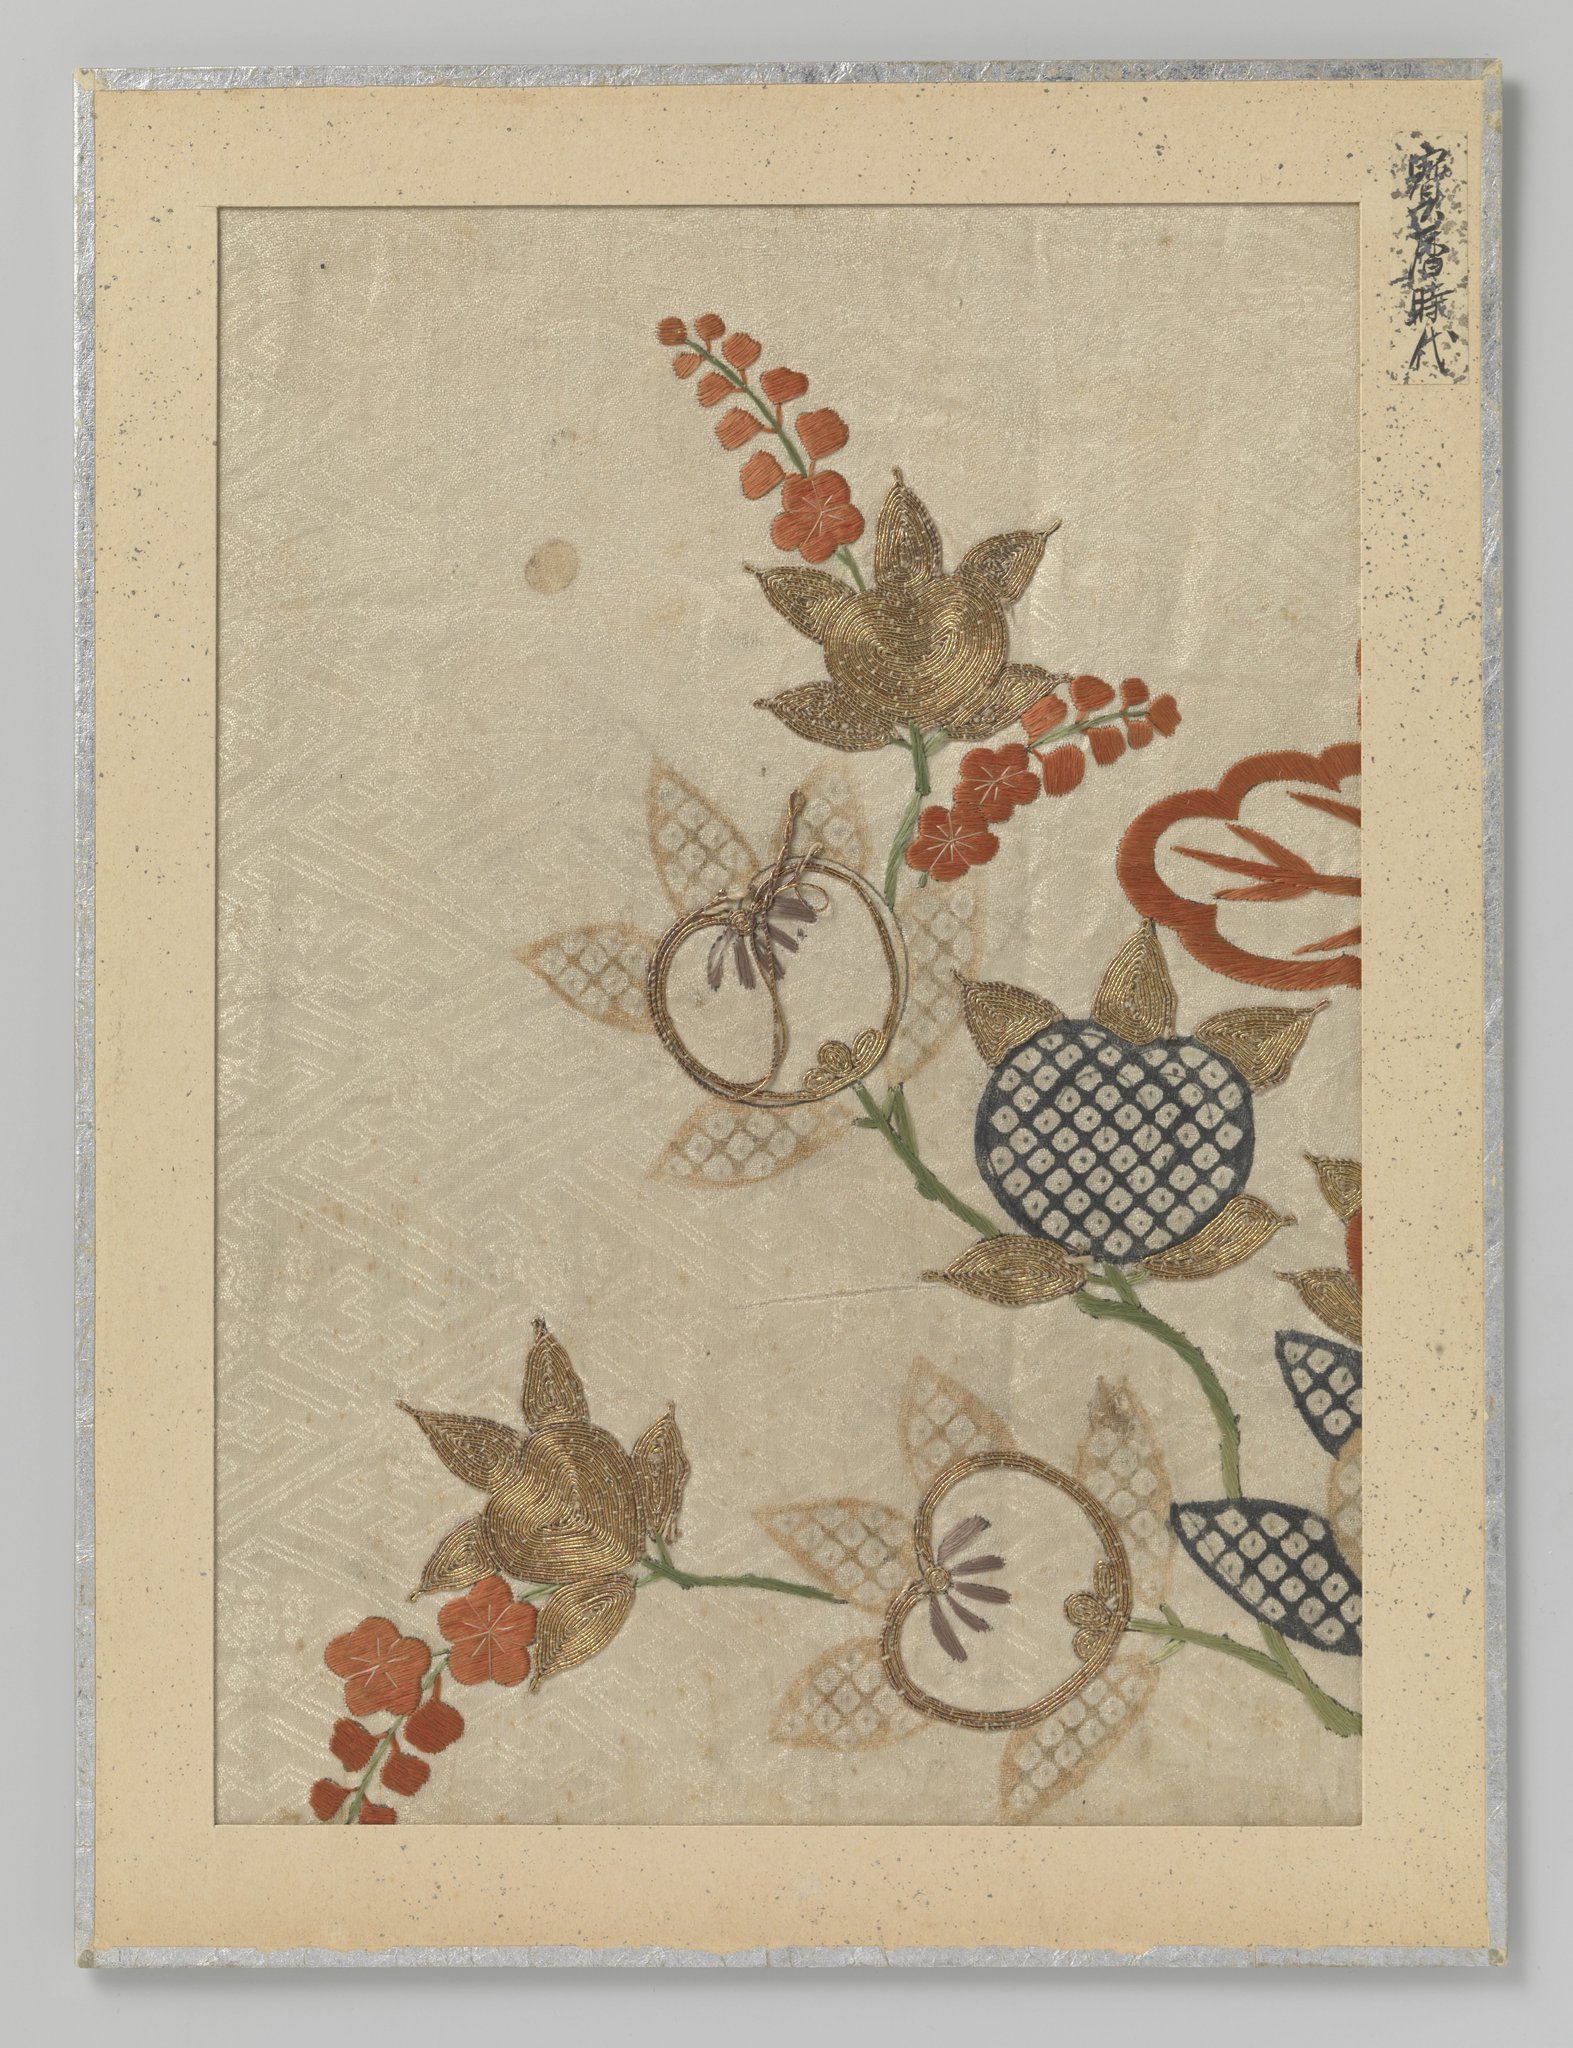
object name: fragment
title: Textielfragment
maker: Anonymous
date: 1751-1764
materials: silk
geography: japan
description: Textielfragment, borduursel en druk van bloemen en takken en vruchten.